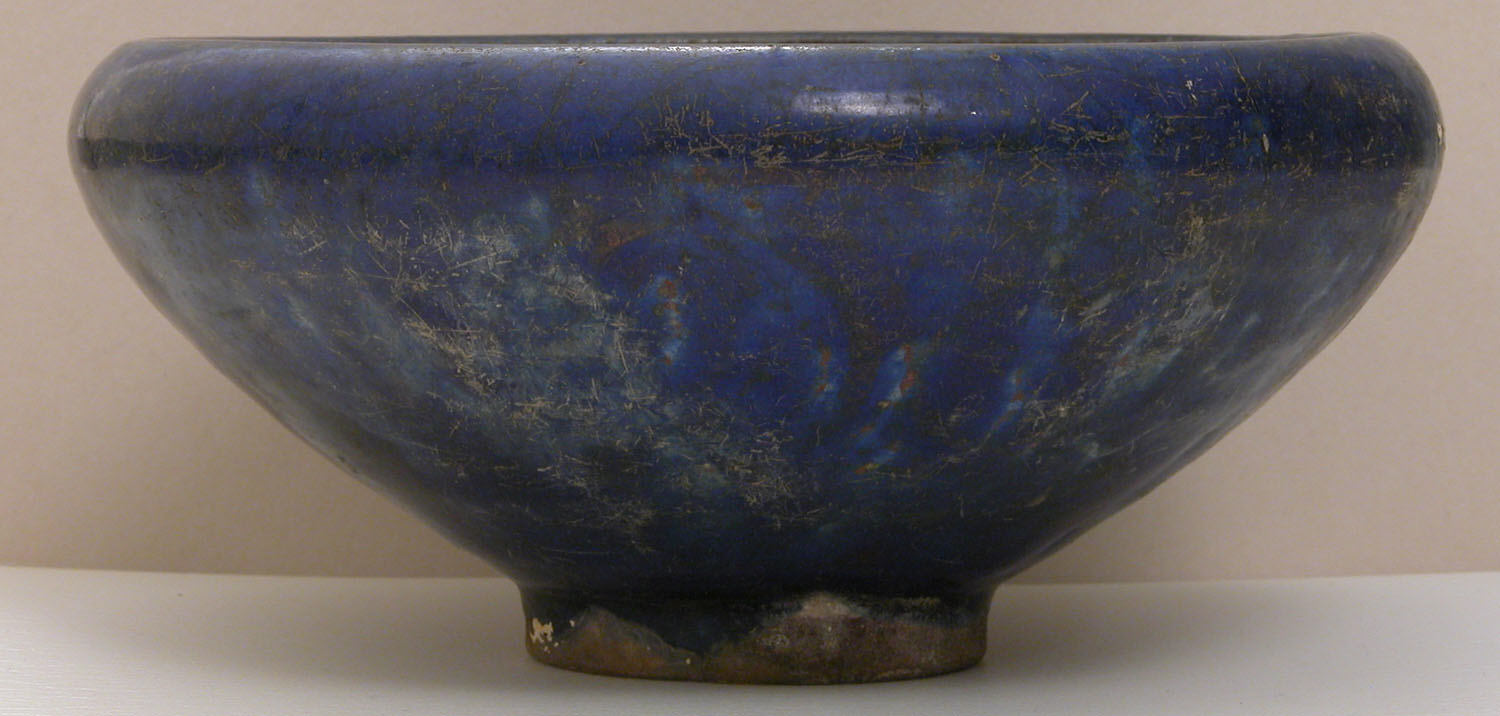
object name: bowl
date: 1201-1400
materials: earthenware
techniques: glazing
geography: iran